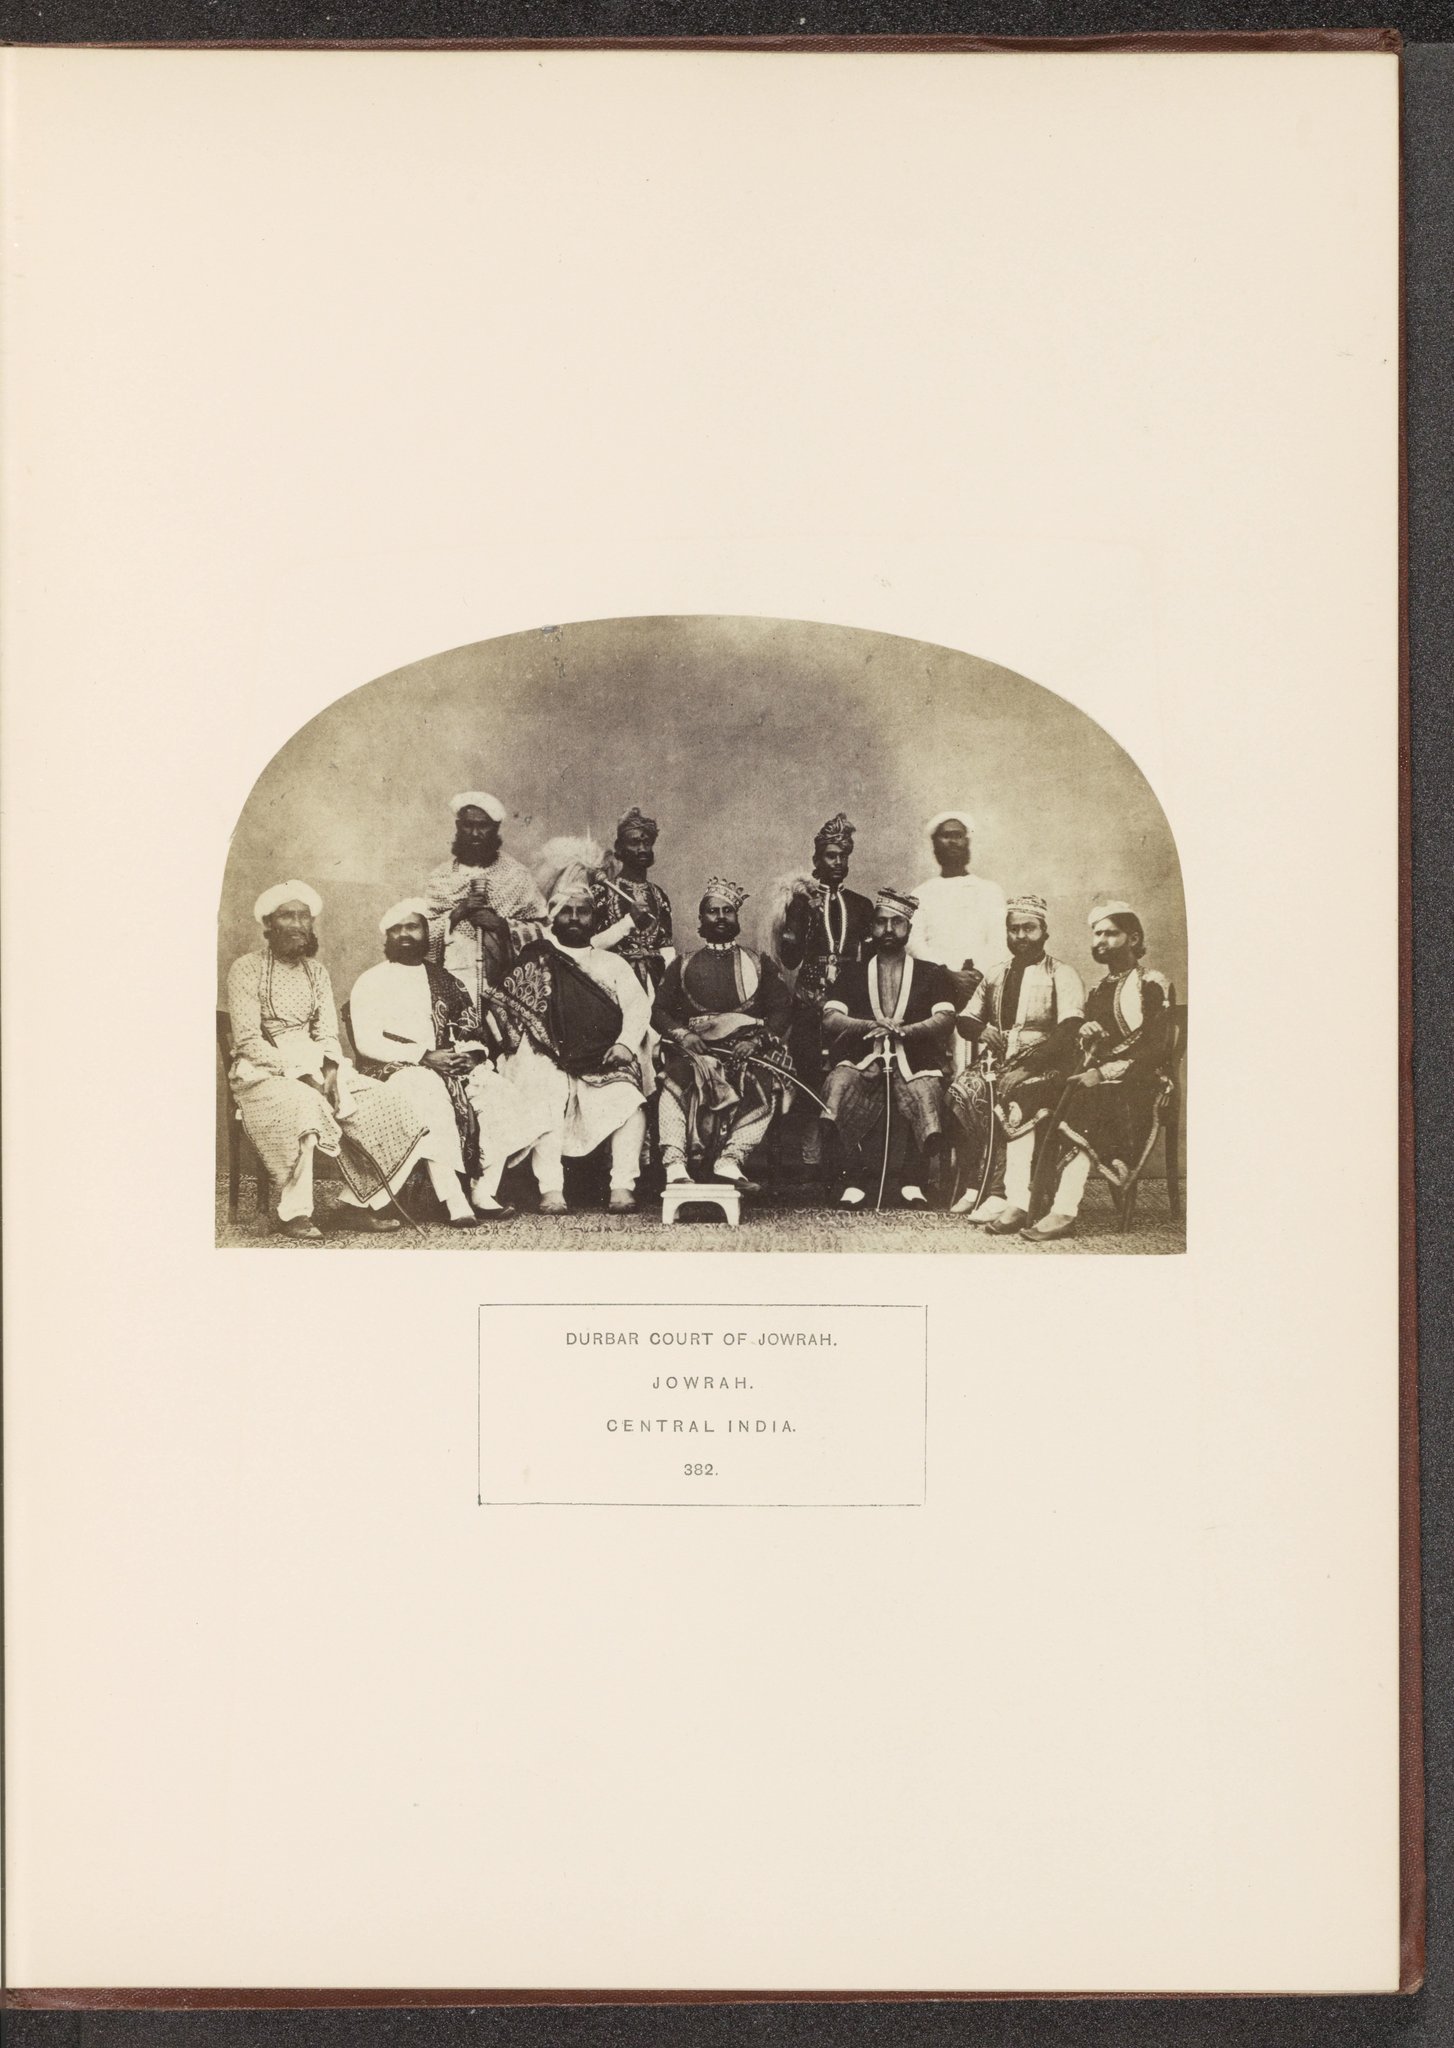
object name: page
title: Portrait of the members of the court of Jaora at a durbar, Jaora, Madhya Pradesh, India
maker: james john waterhouse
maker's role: fotograaf, luitenant, officier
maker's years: 1842-1928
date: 1862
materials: photographic support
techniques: albumen print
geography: jaora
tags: family of a ruler, and court, ruler, sovereign, human races; peoples; nationalities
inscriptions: number: ‘382.’, inscription: ‘DURBAR COURT OF JOWRAH./ JOWRAH./ CENTRAL INDIA.’